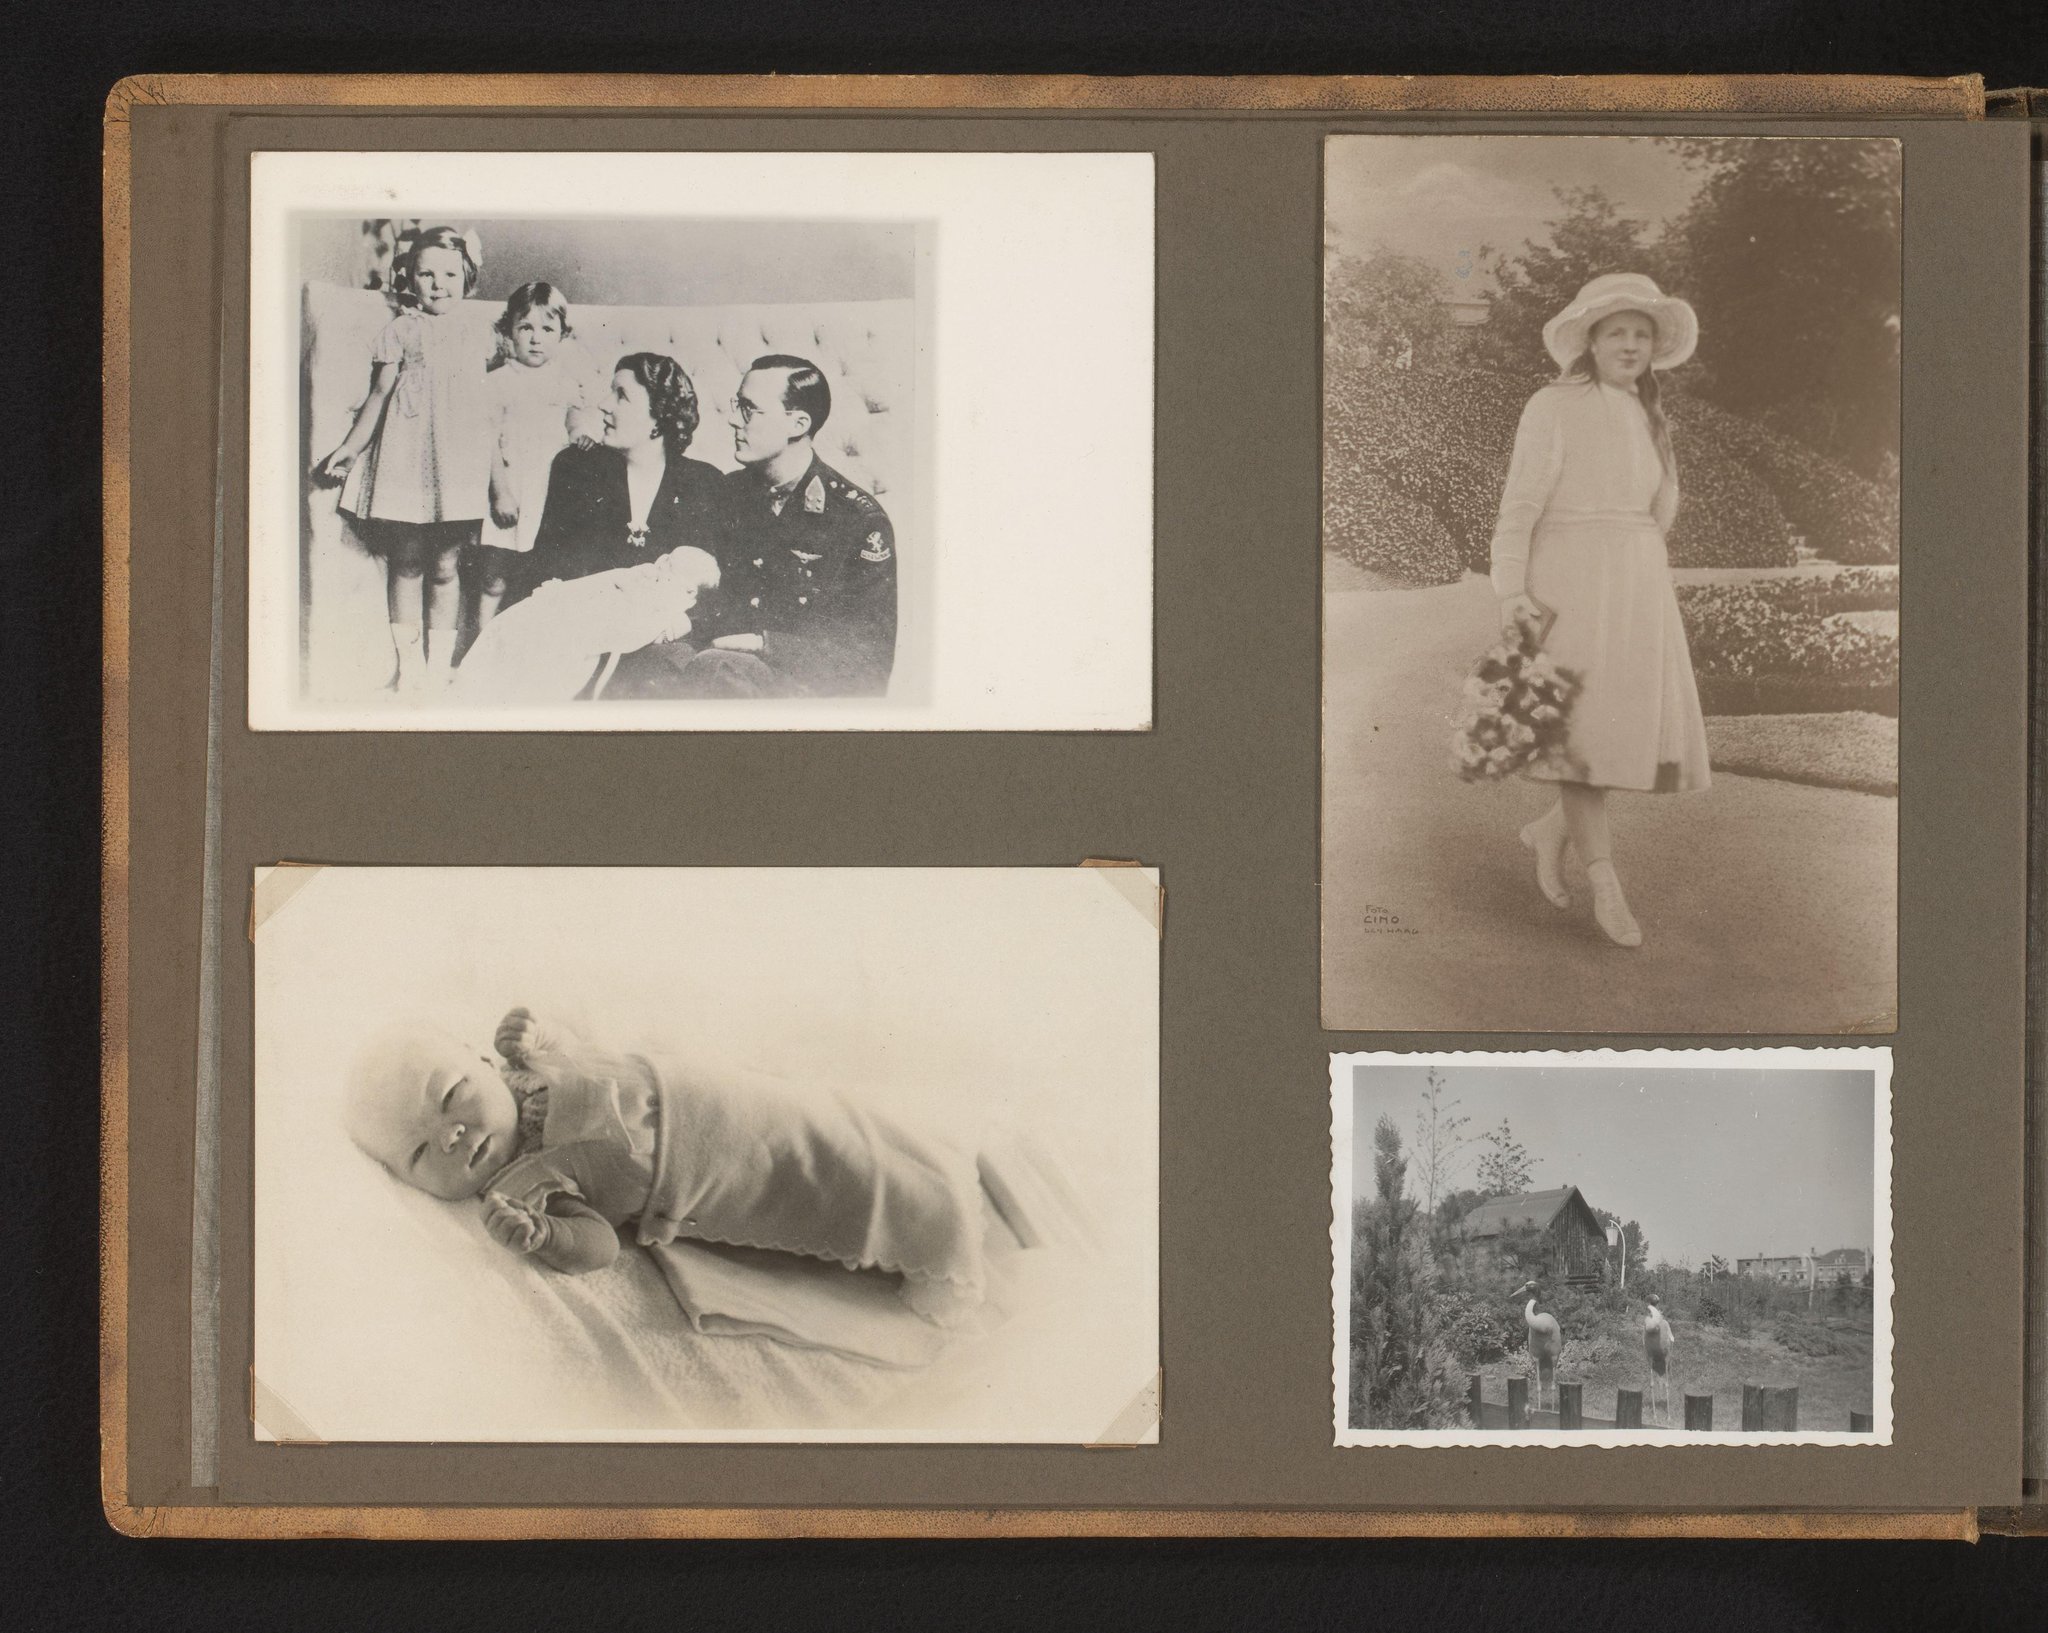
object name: photograph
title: Portretten van leden van het Koninklijk Huis en een gezicht op een tuin met vogels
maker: Anonymous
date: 1900-1950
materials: photographic support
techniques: gelatin silver print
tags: utrecht, bernhard (prins der nederlanden), beatrix (koningin der nederlanden), juliana of the netherlands, adult woman, birds, adult man, historical persons, infant, baby, family of the sovereign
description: Portret van onder andere koningin Juliana, prins Bernhard, koningin Beatrix, prinses Irene en prinses Margriet. Deze pagina maakt deel uit van een album.